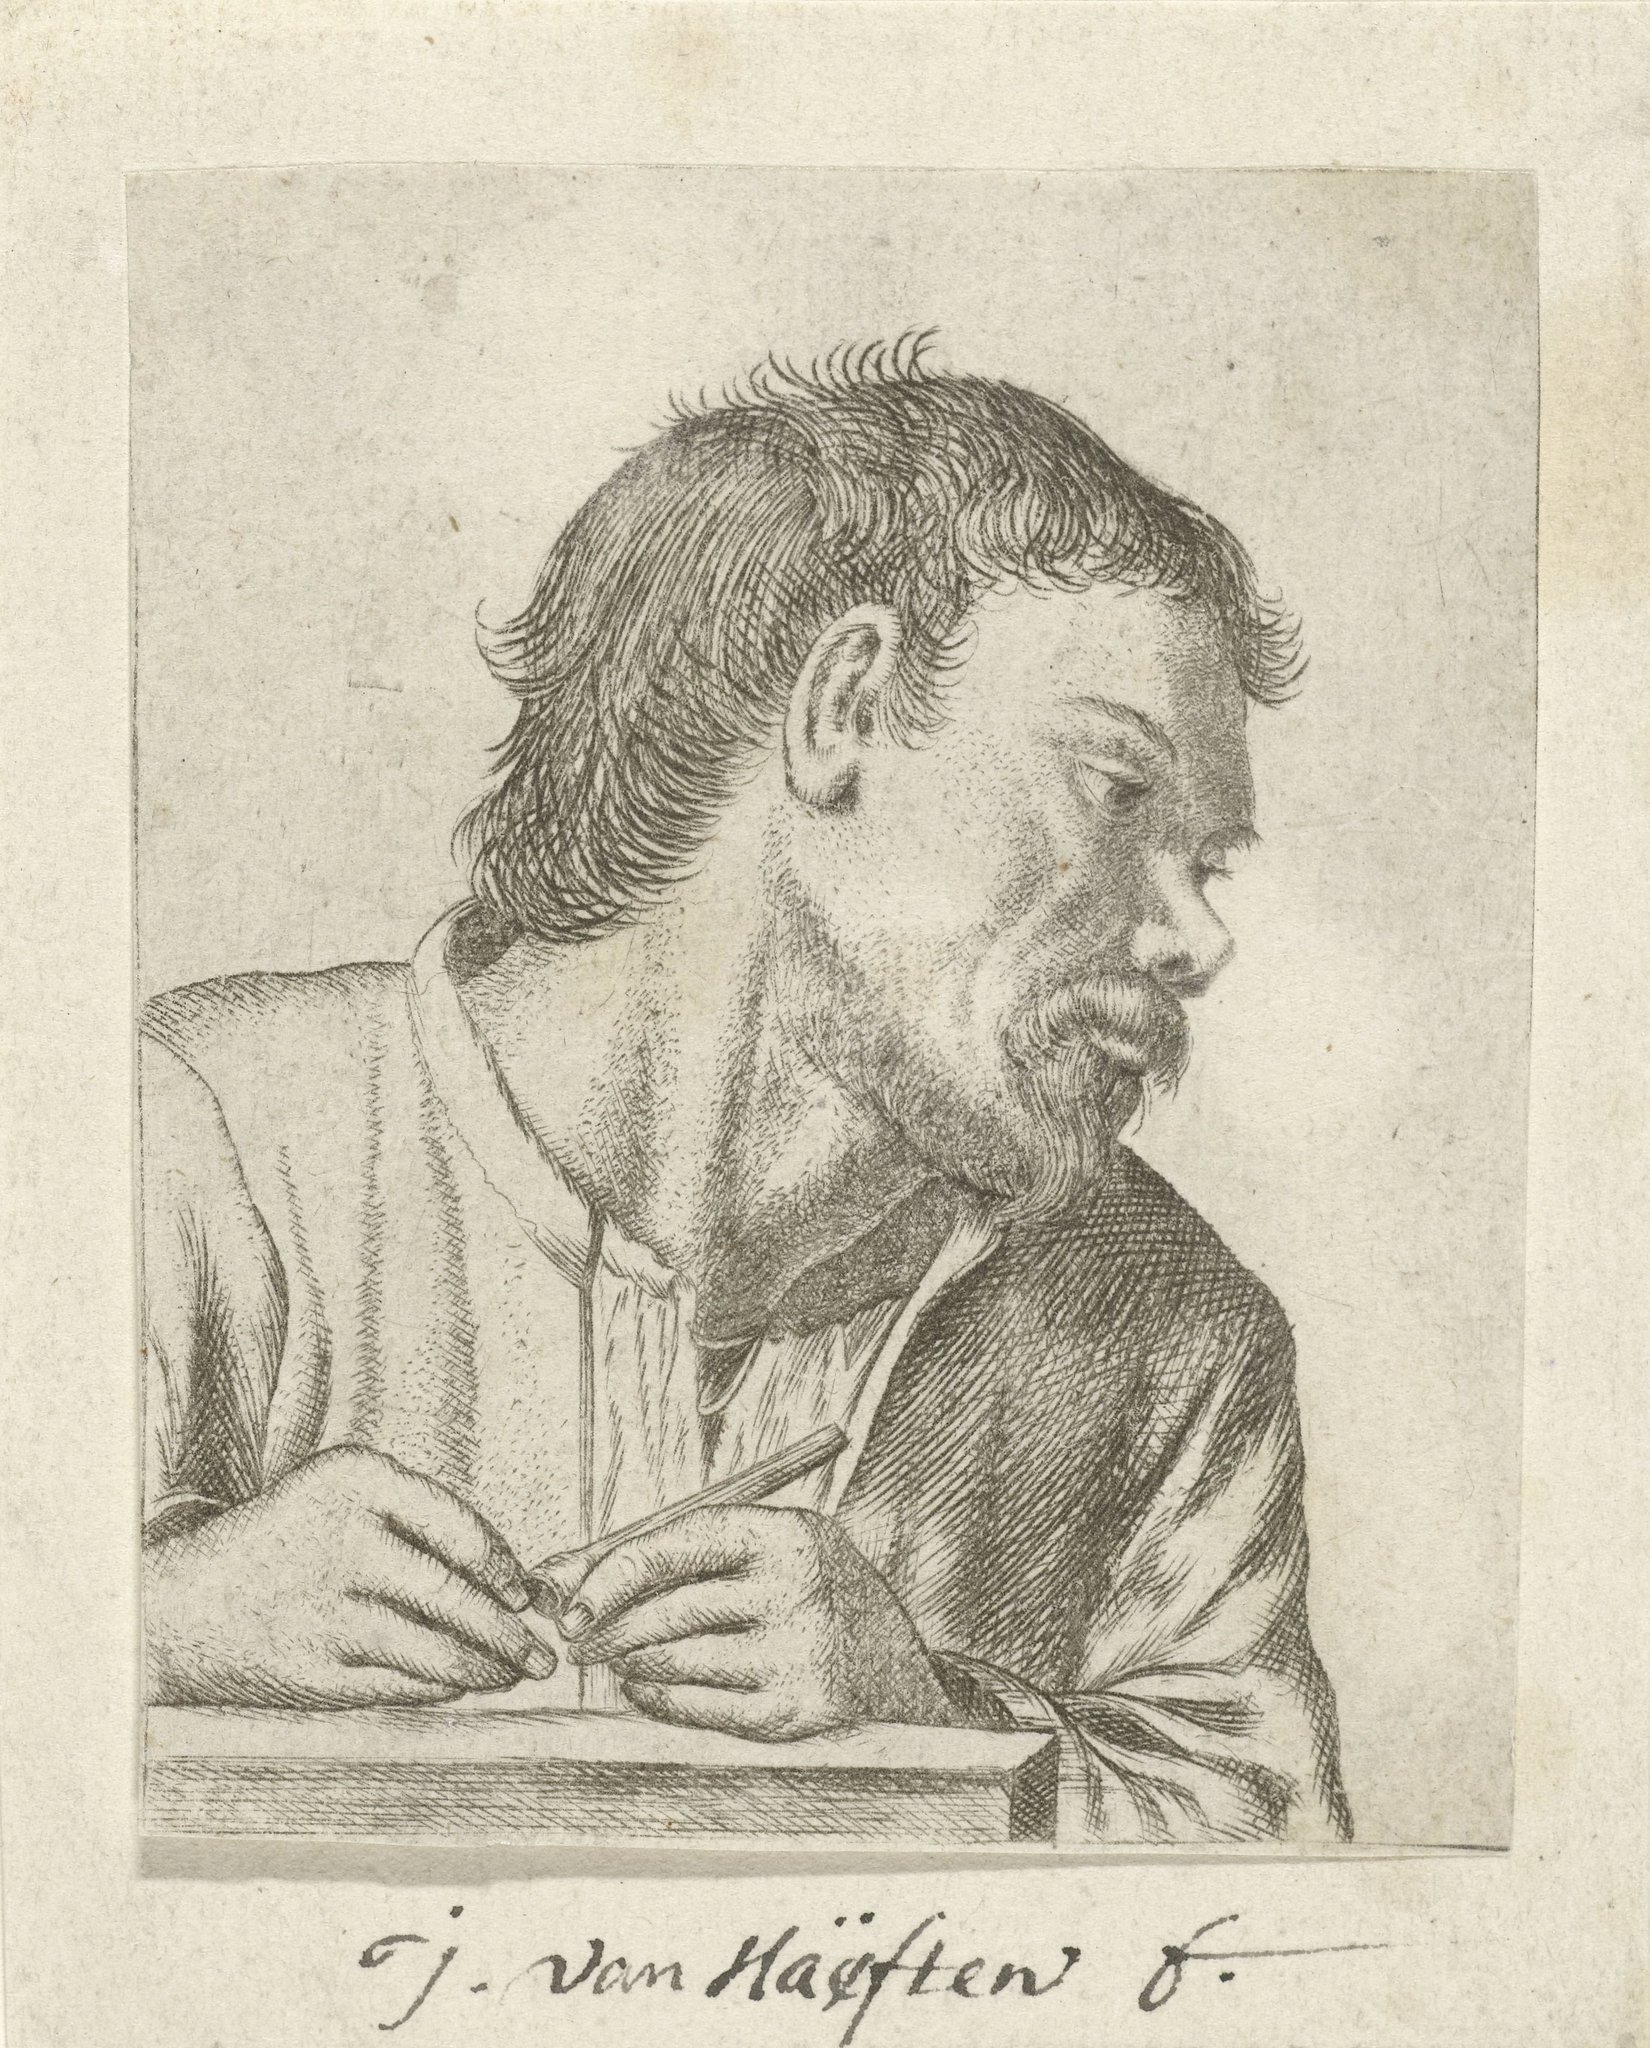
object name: print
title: Man die een pijpje stopt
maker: j. van haeften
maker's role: print maker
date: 1600-1699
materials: paper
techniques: etching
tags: pipe ~ tobacco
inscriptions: collector's mark: Lugt 2228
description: Een man stopt zijn pijpje, zijn handen rustend op een plint.